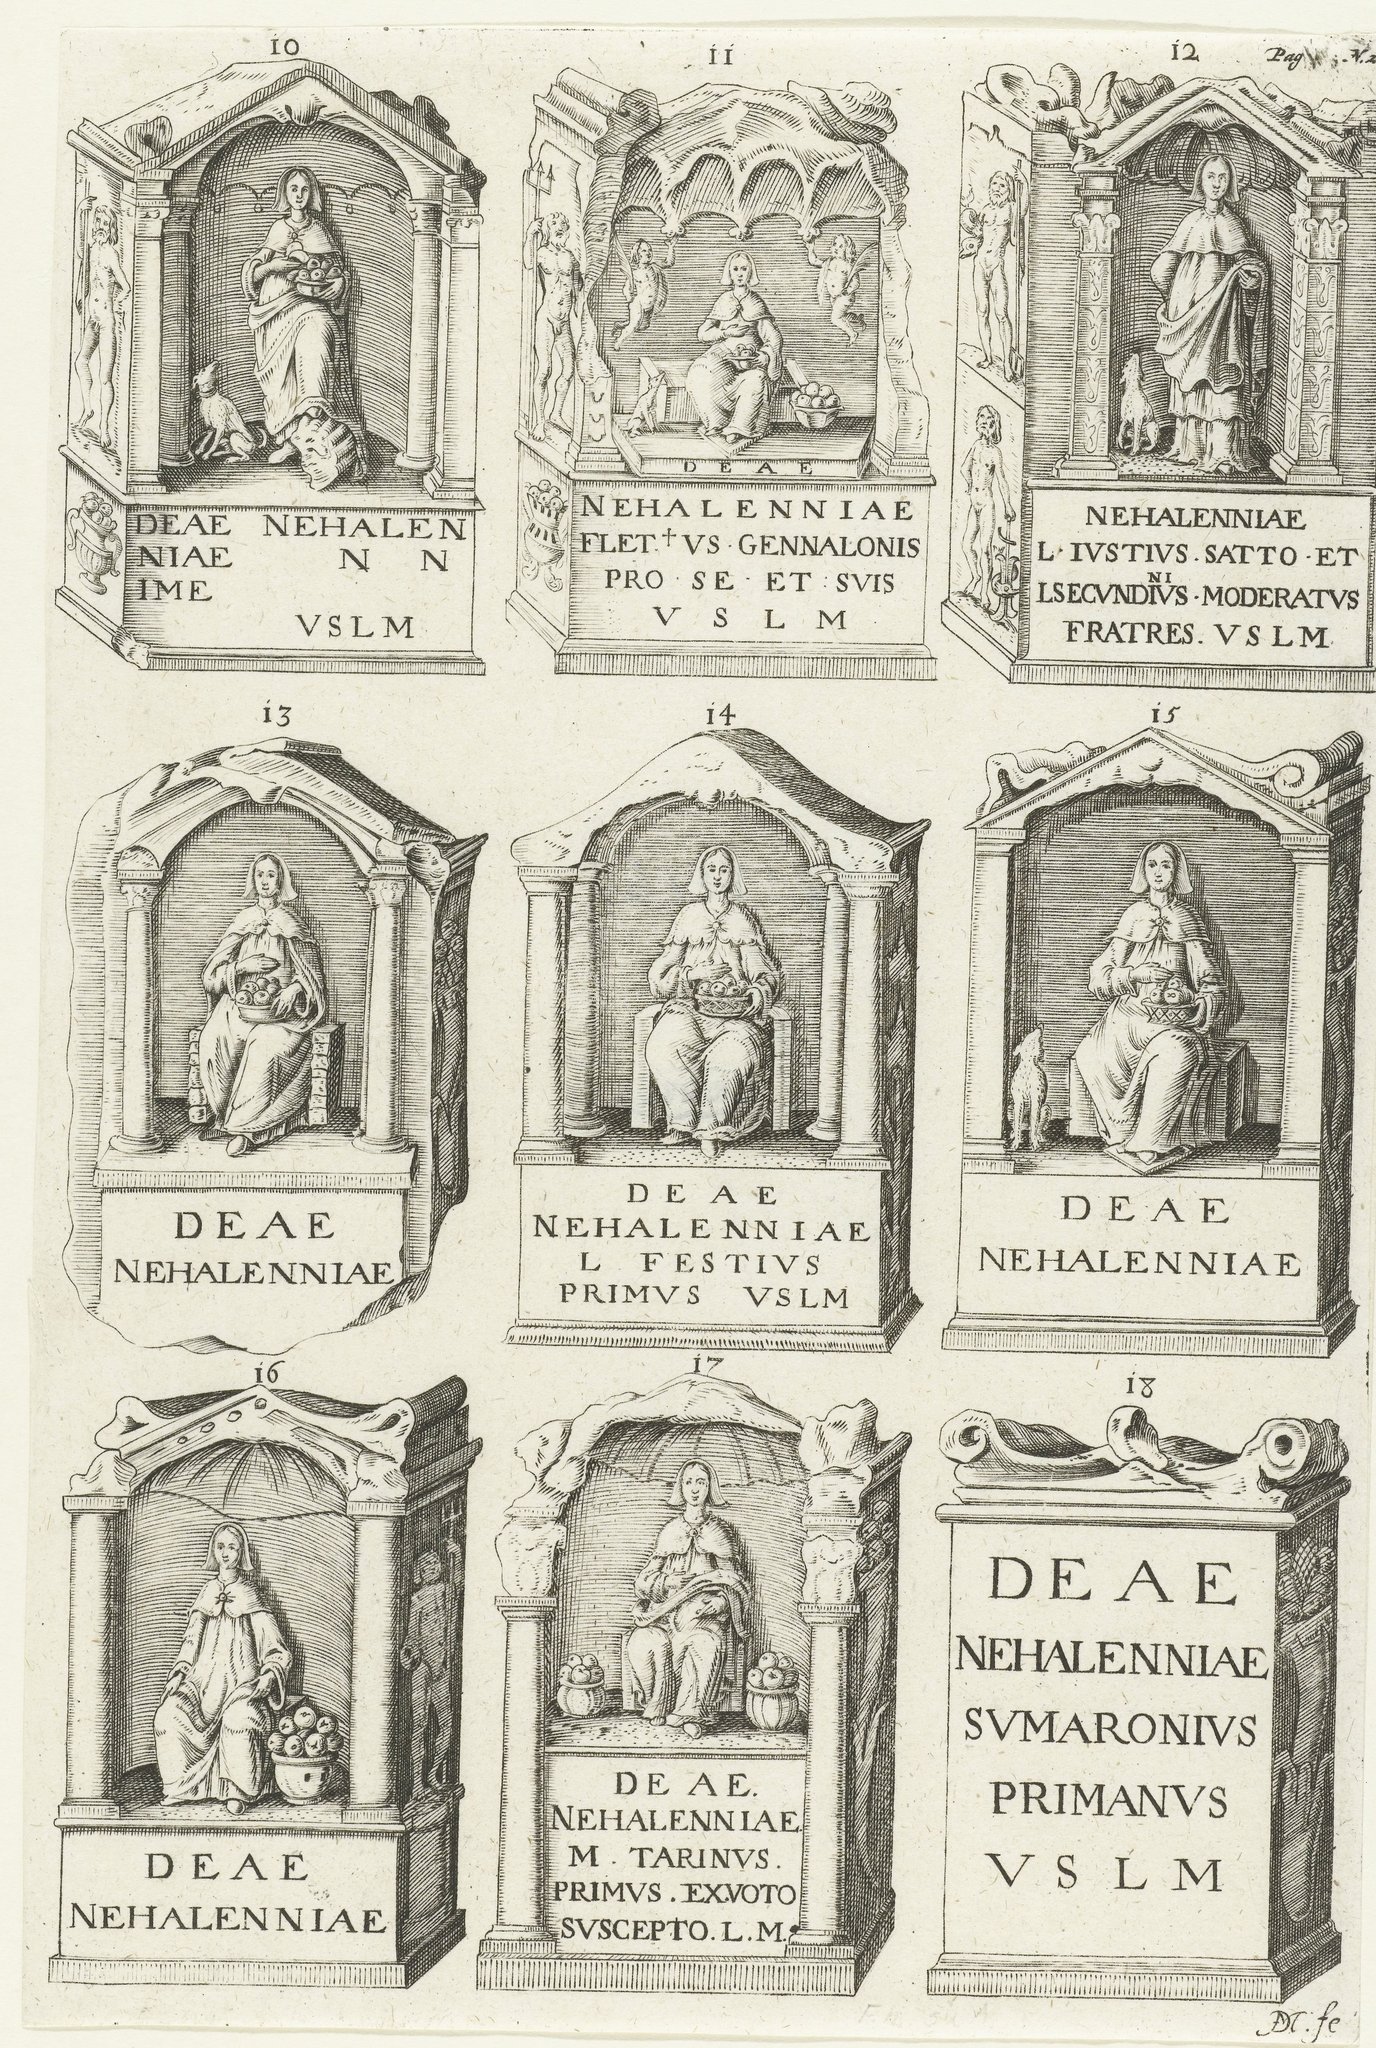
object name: historical object representation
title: Nehalennia-altaren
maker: jan de mel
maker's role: print maker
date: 1648-1650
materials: paper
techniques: engraving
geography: netherlands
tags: other foreign deities included in the classical pantheon (with name)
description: Blad met overzicht van altaren met Nehalennia, genummerd 10-18. Afkomstig uit: Olivier de Wree, Historiae comitum Flandriae libri prodromiduo, Lucas van den Kerchove, Brugge 1650. Eerste staat met rechtsboven: Pag. ..., No. 2.